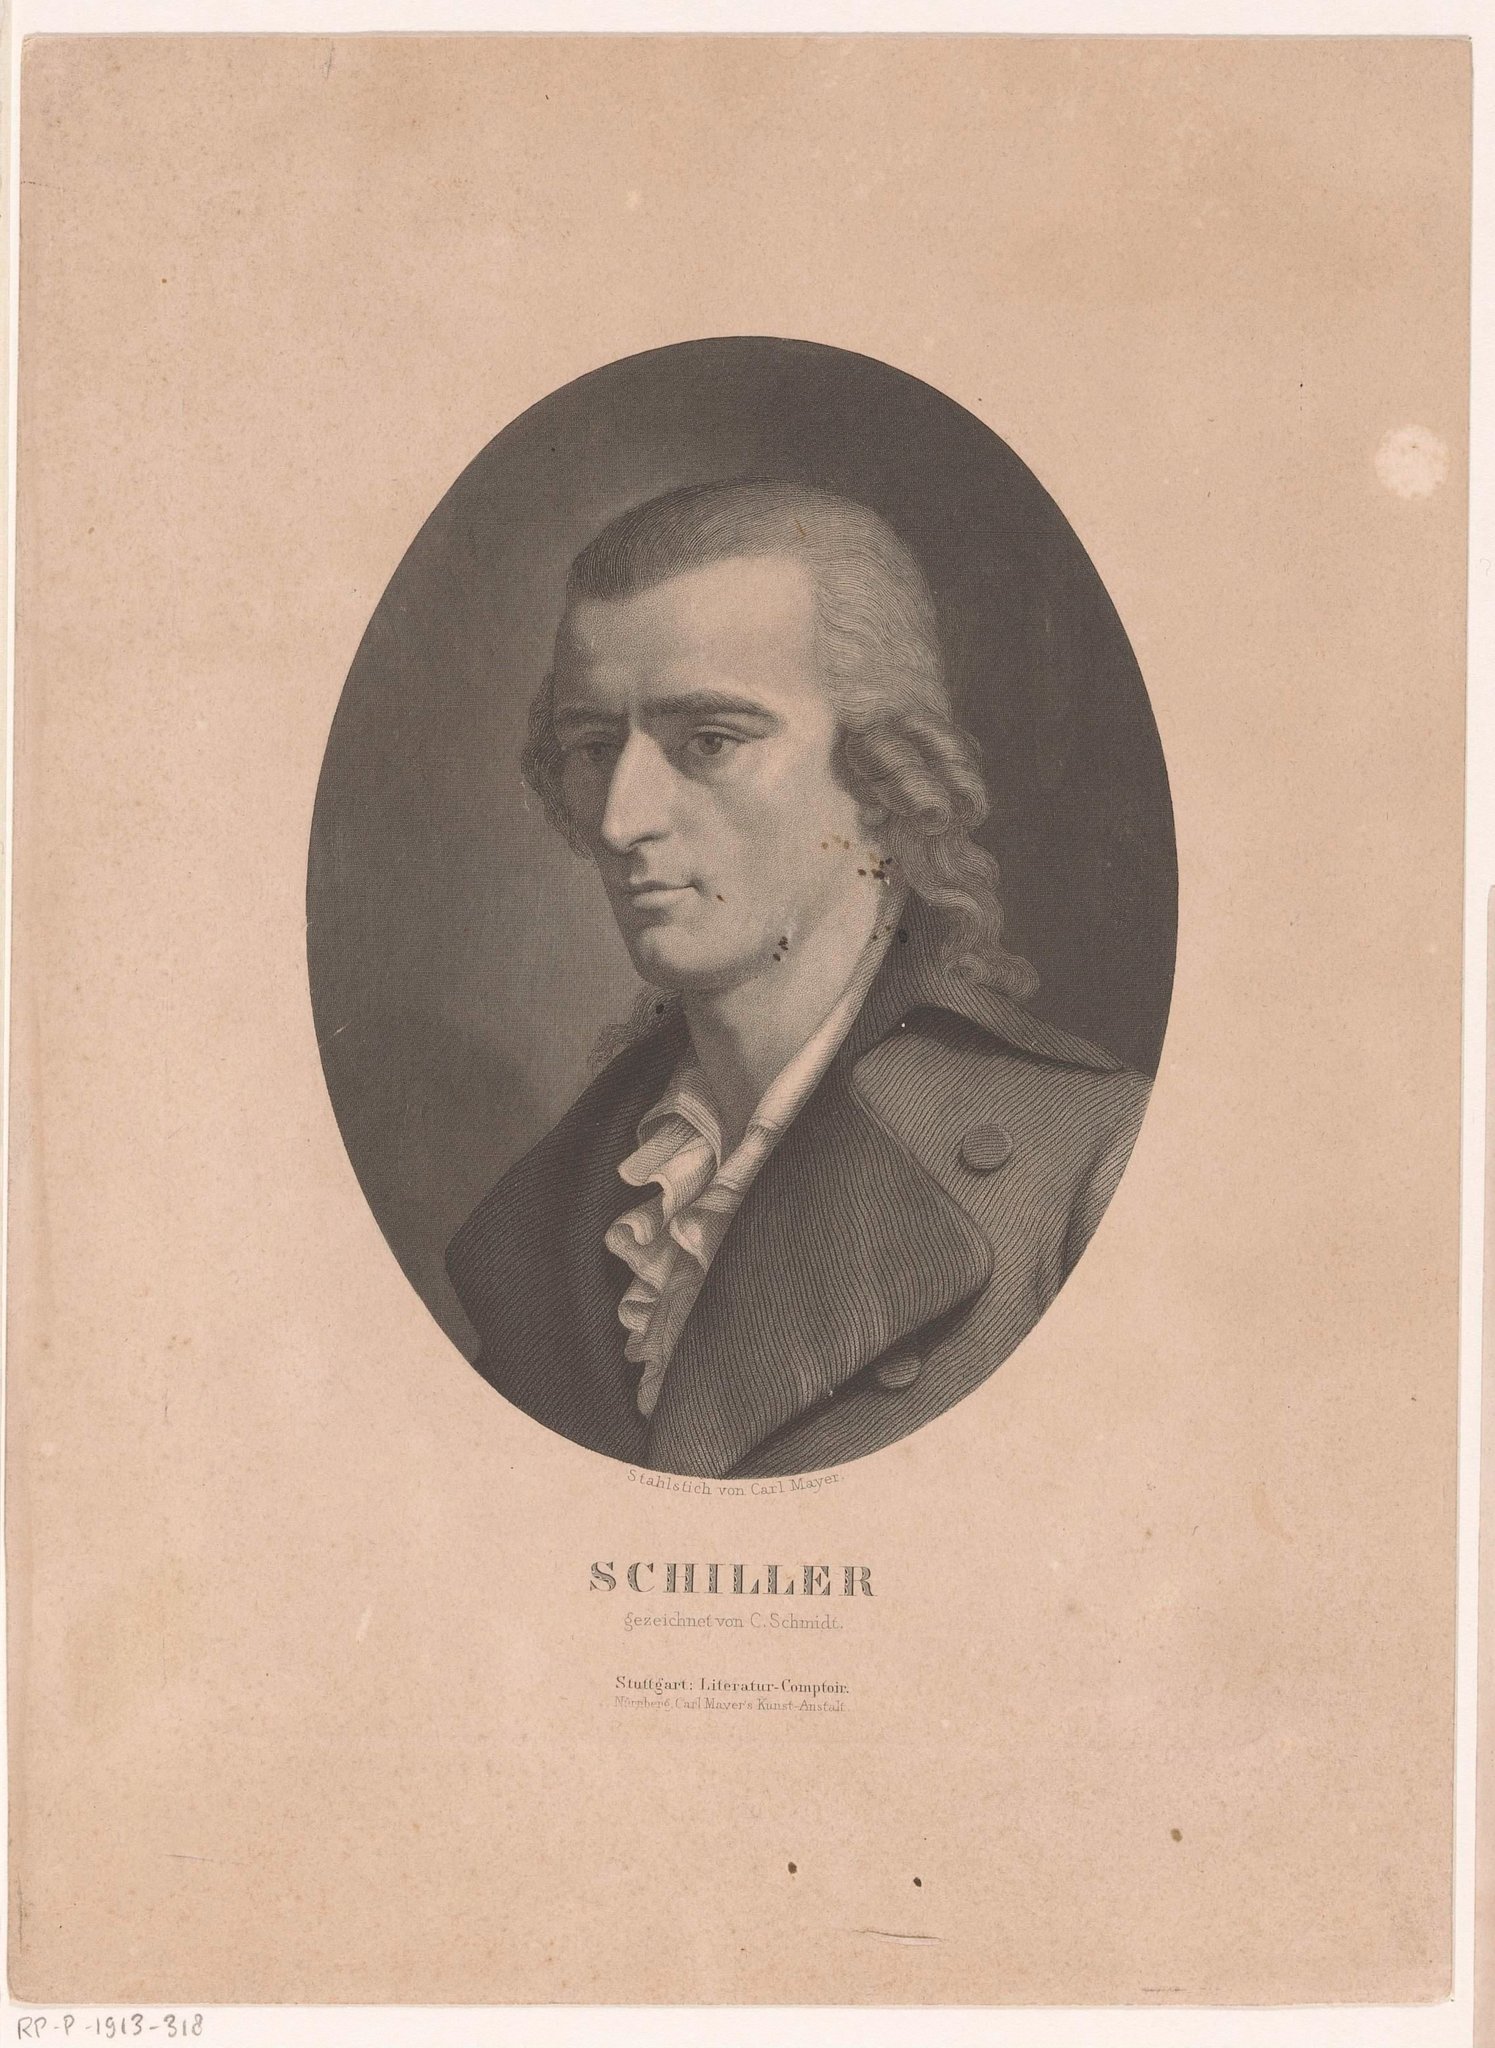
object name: print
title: Portret van Friedrich von Schiller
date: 1808-1868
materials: paper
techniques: engraving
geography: nuremberg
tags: friedrich von schiller, historical persons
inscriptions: collector's mark: Lugt 2228